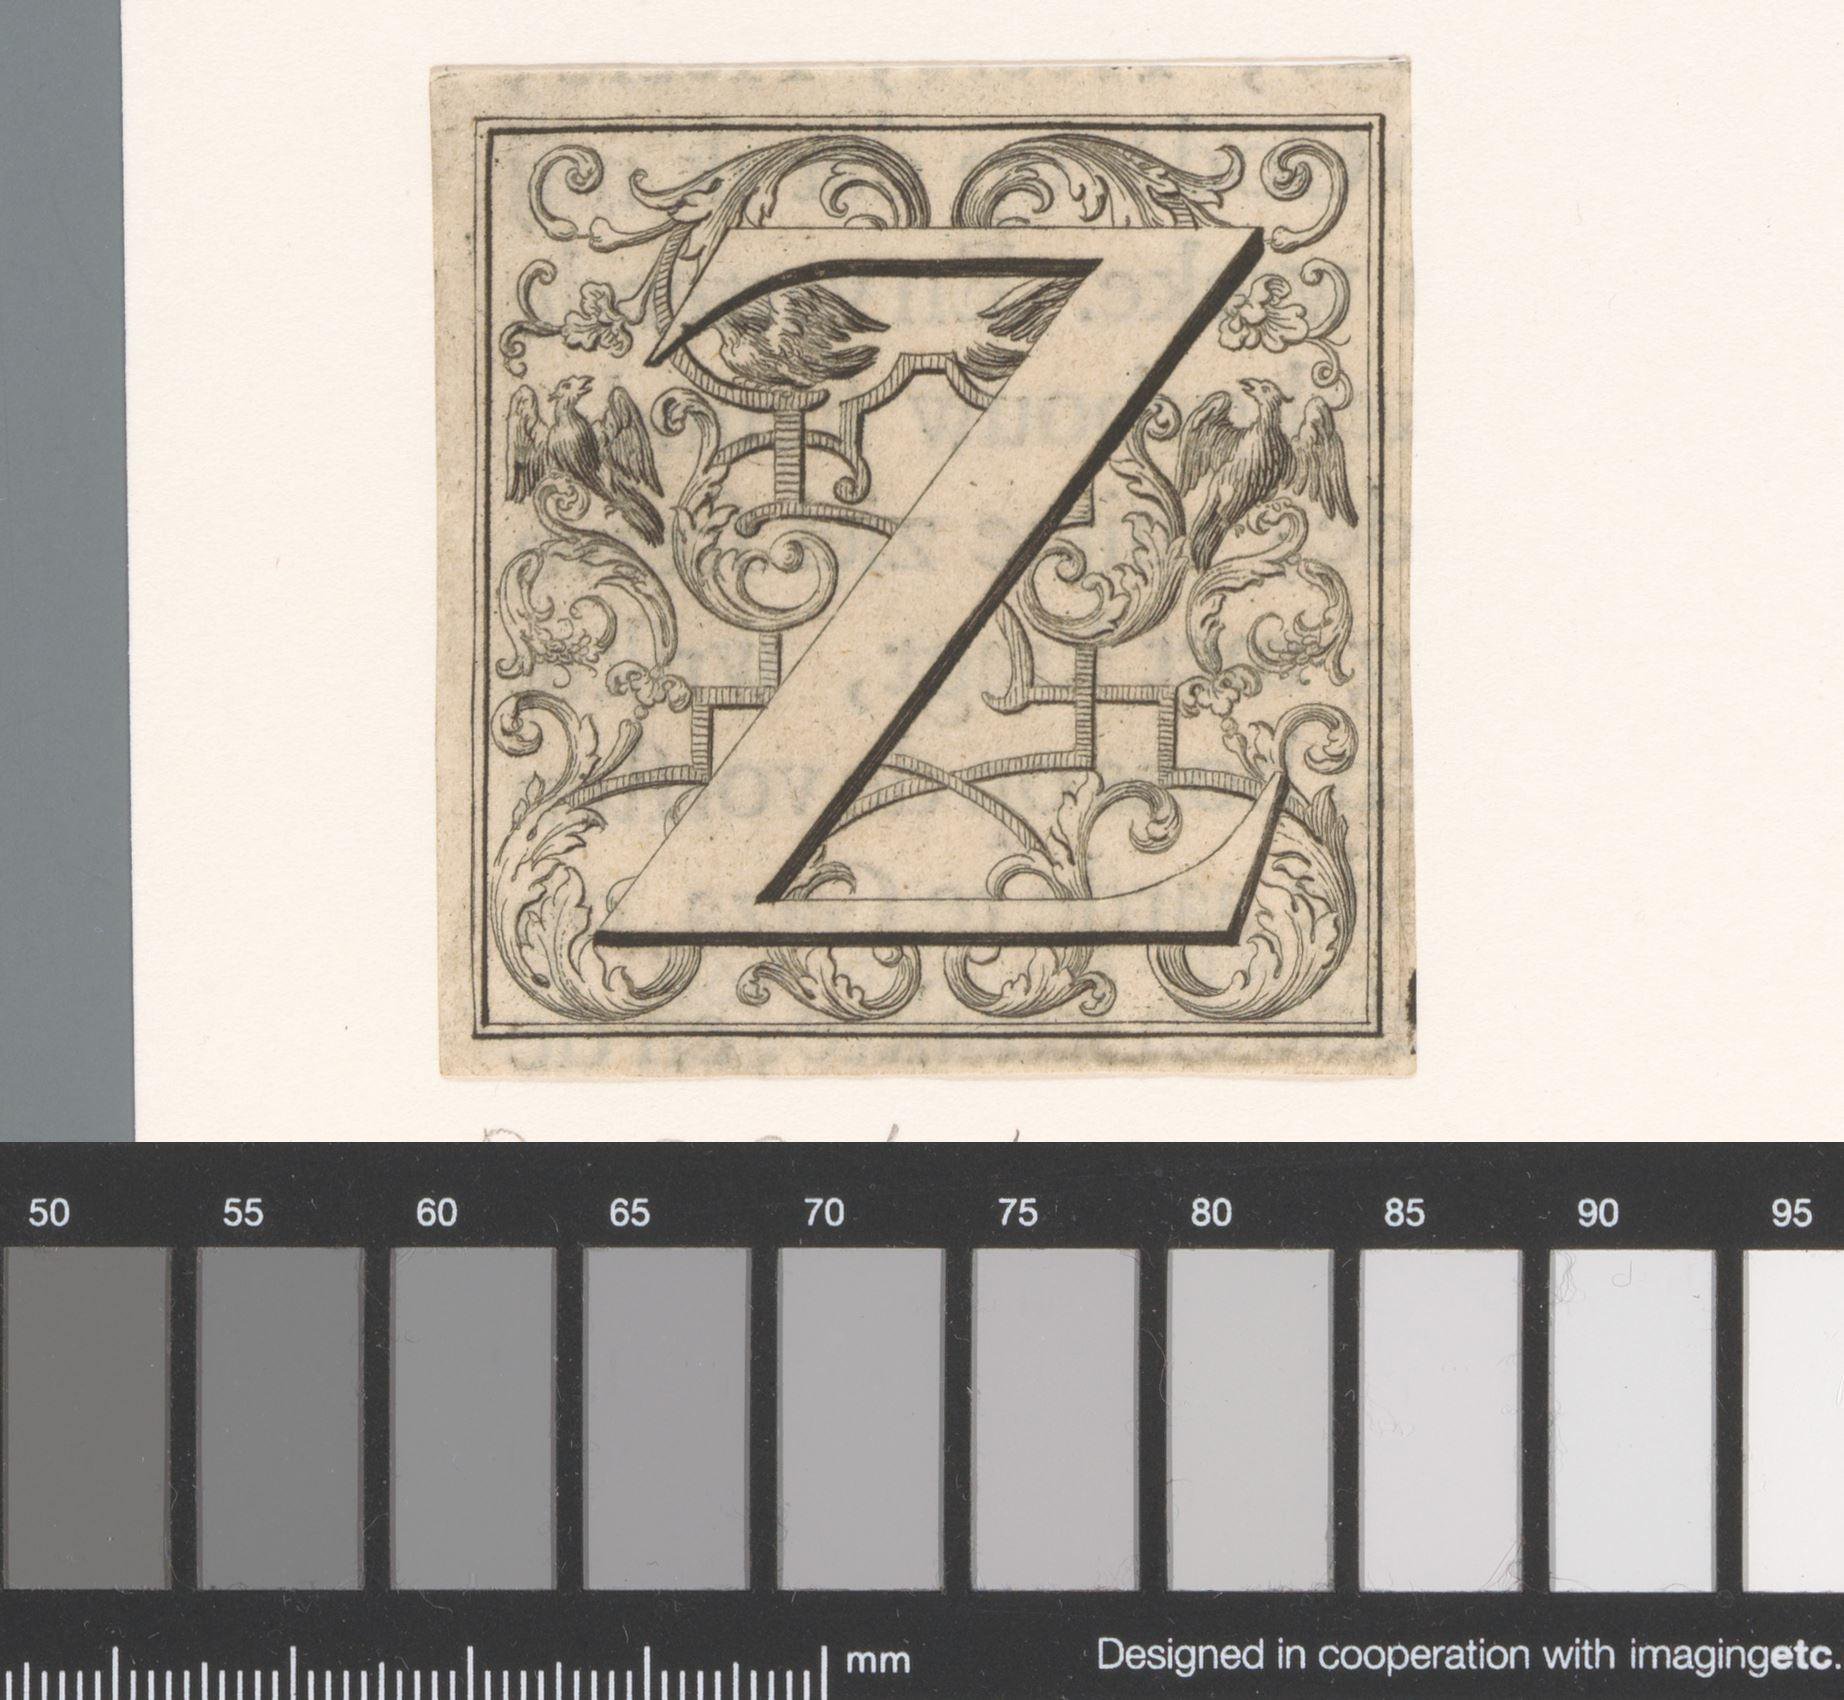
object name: print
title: Letter Z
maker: Anonymous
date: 1700-1799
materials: paper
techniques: etching, letterpress printing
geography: netherlands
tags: fancy letters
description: Letter Z tegen een achtergrond met vlechtwerk en vogels.